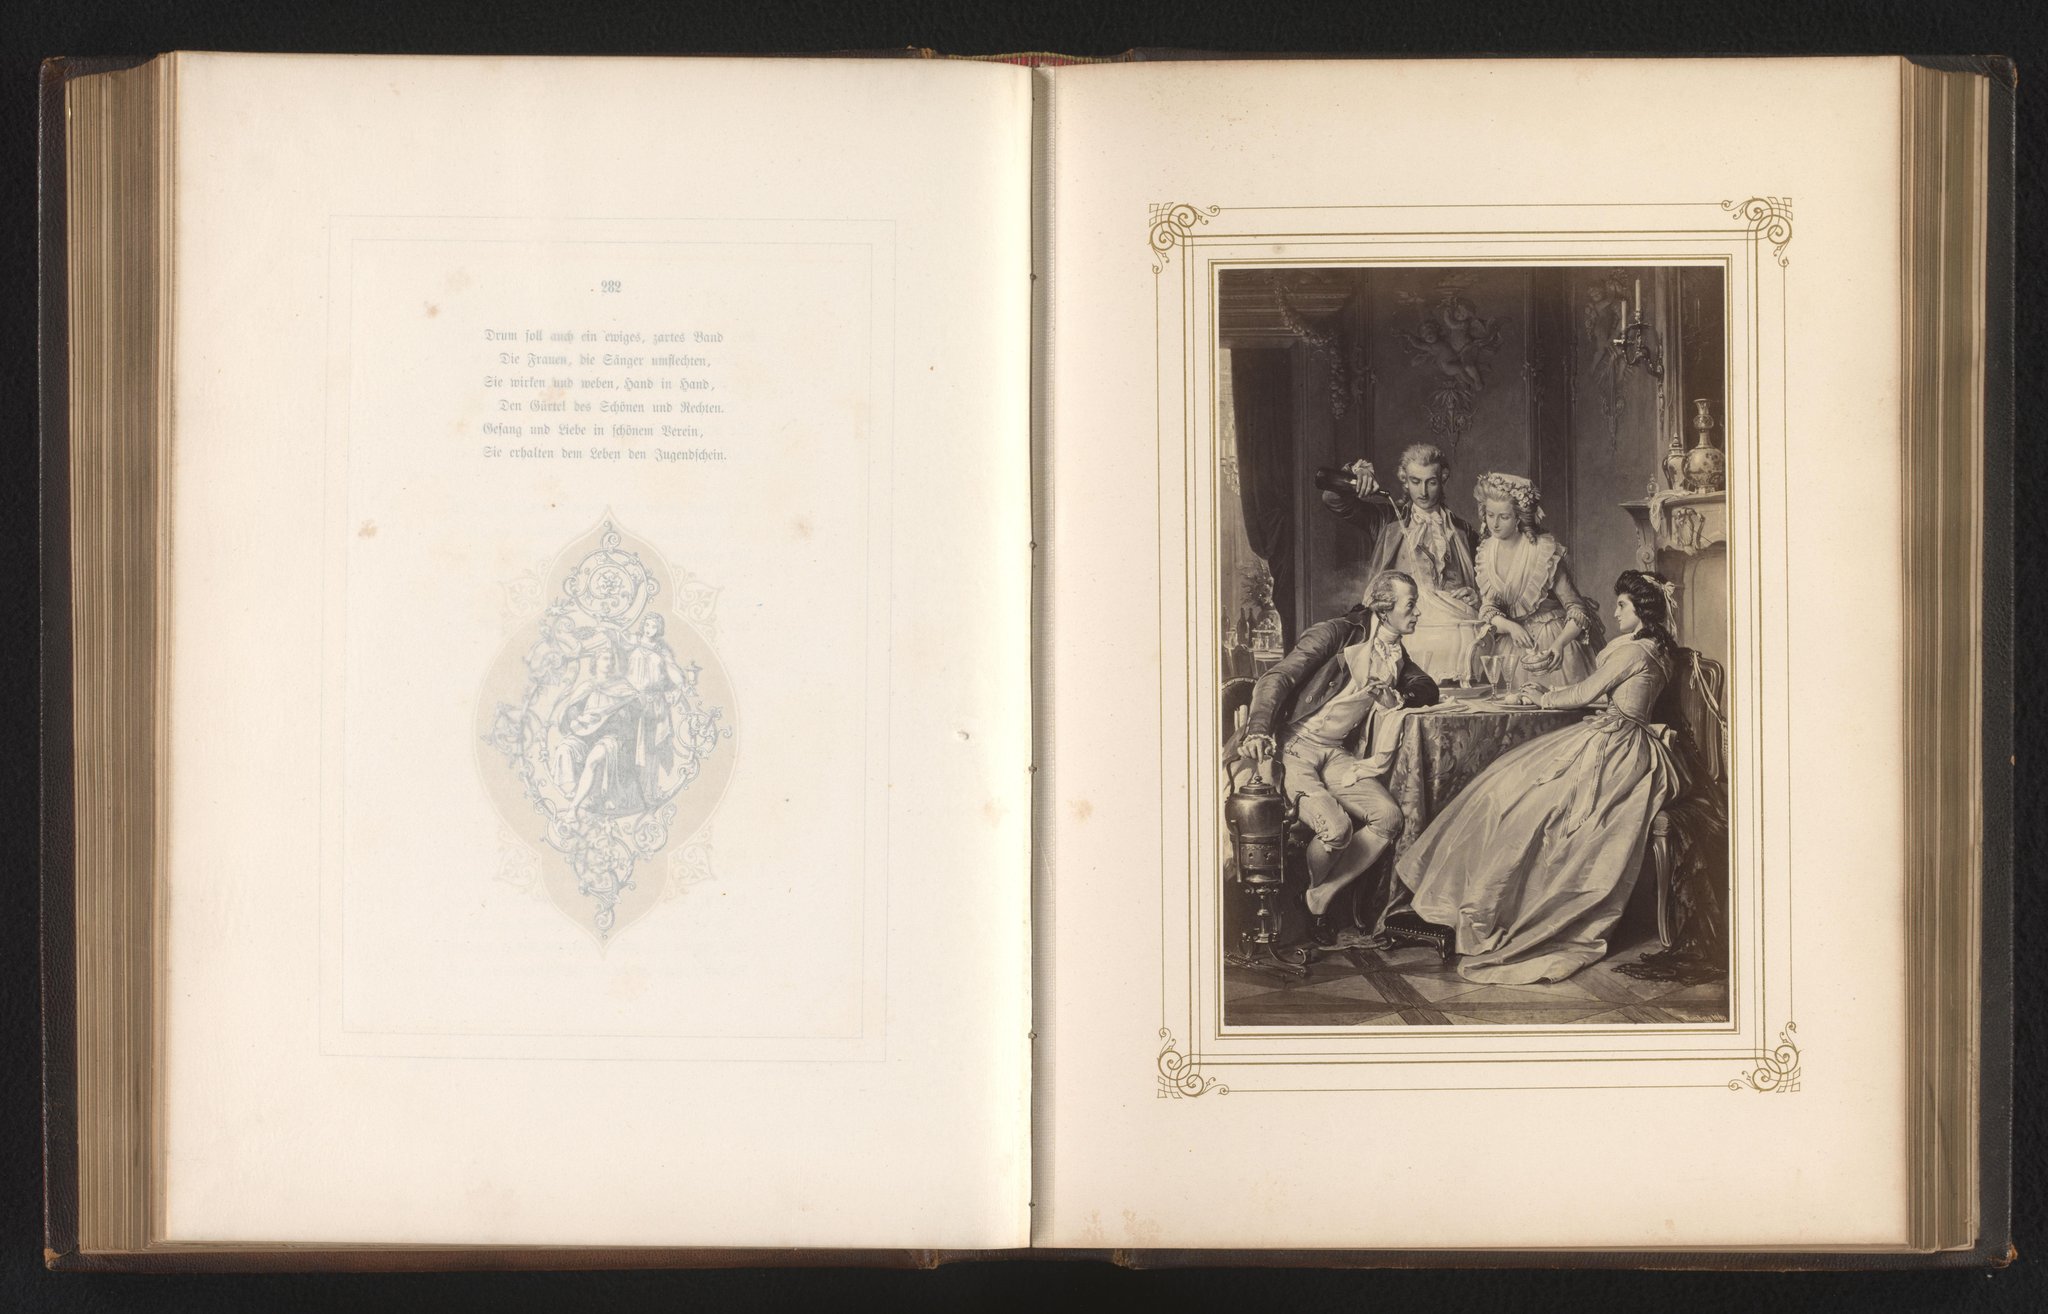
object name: page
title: Fotoreproductie van een tekening van een drankgezelschap door Arthur von Ramberg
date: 1855-1862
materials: paper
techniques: albumen print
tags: reception, cocktail party, alcoholic drinks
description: Foto op ongenummerde pagina na pagina 282.